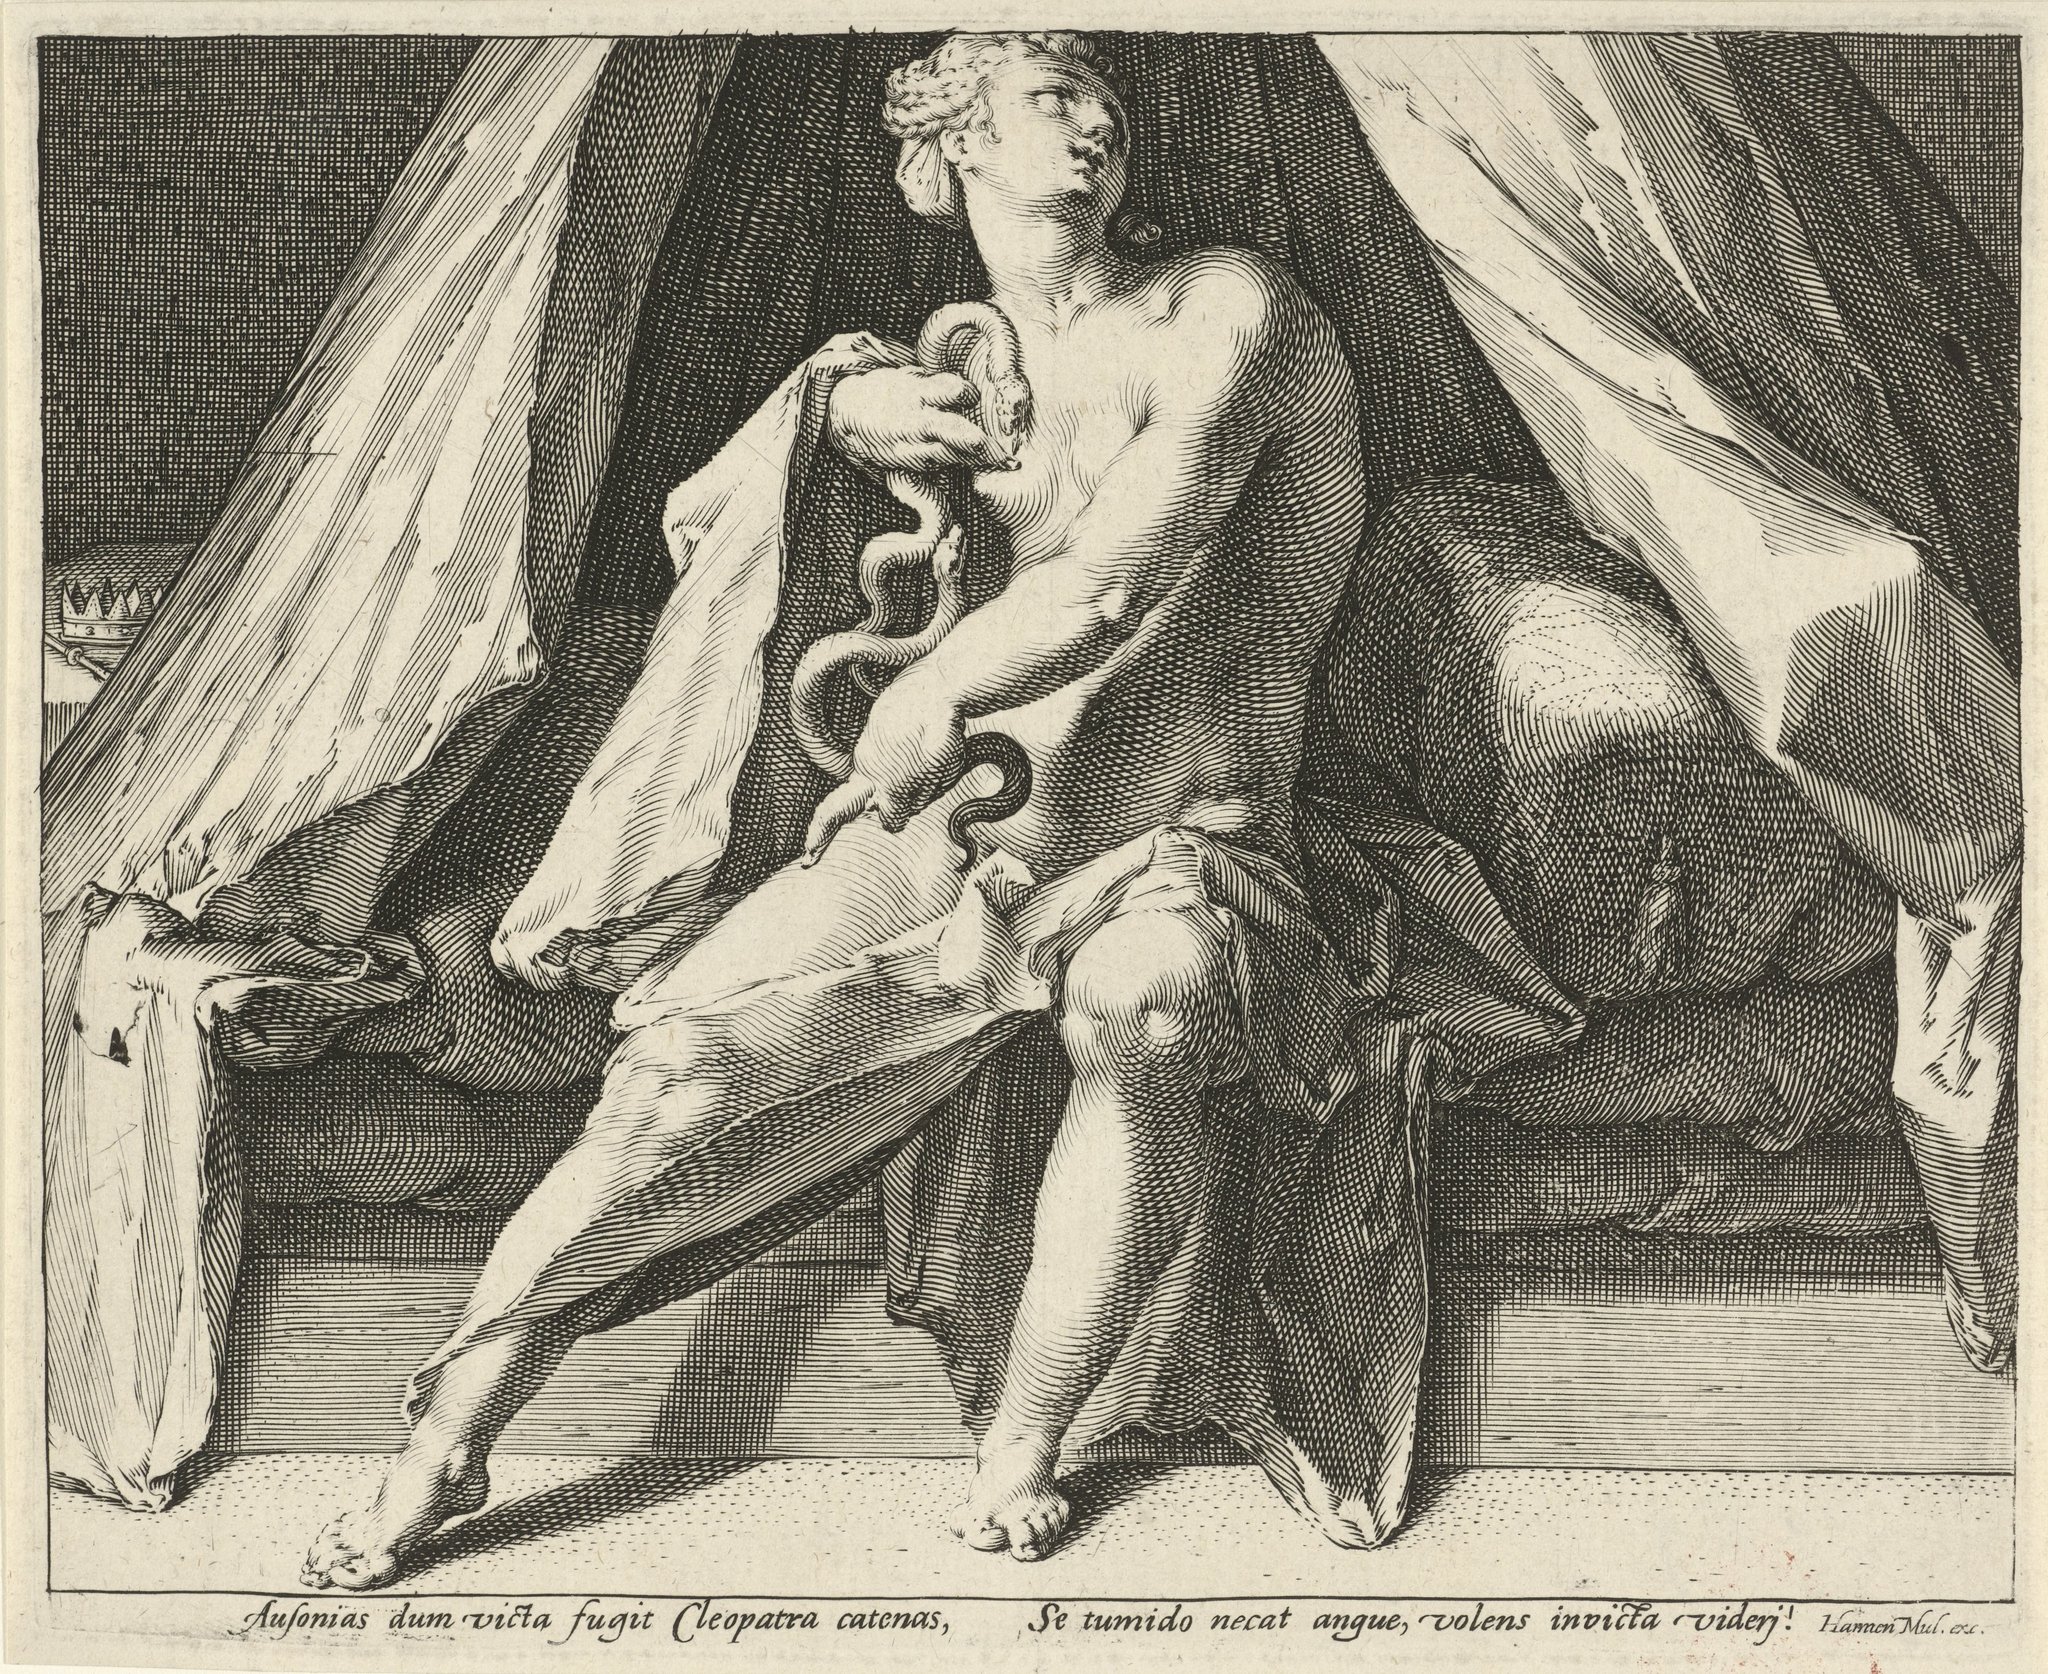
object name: print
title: Dood van Cleopatra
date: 1590-1594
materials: paper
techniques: engraving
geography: amsterdam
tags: death of cleopatra: she commits suicide by holding to her breast an asp, which she has taken from a basket of figs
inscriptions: collector's mark: Lugt 240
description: Cleopatra pleegt zelfmoord door zich door een cobra te laten bijten. Ze zit naakt op haar bed. Rechts van het bed haar kroon en scepter.